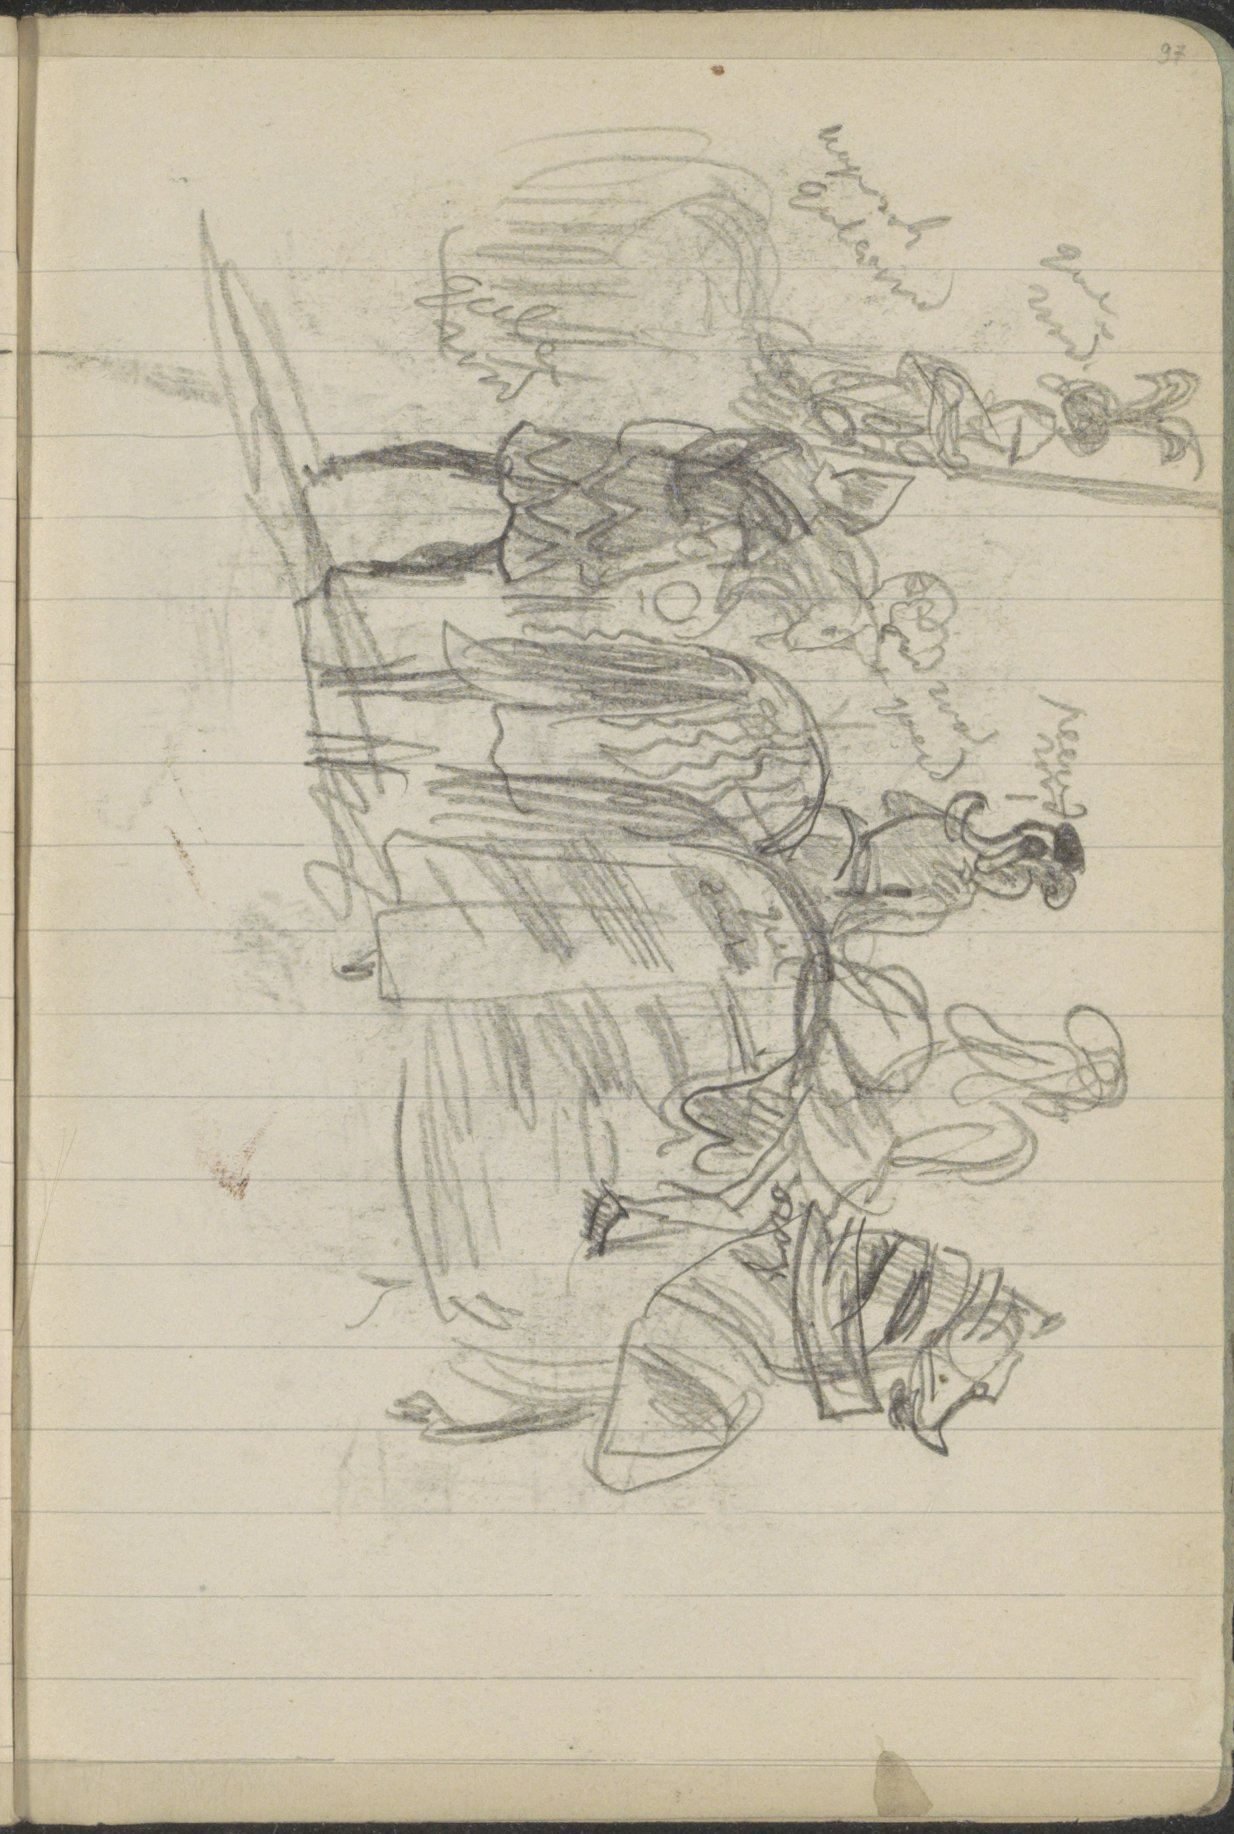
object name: sketchbook leaf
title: Ruiters in harnas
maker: marius bauer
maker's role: draughtsman, print maker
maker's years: 1867-1932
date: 1902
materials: pencil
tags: riding a horse, ass, or mule; rider, horseman, saddle and bridle (saddlery), armour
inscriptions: kleurnotitie, handgeschreven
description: Tevens een staande figuur in harnas. De paarden waarop de ruiters rijden zijn versierd. Pagina 97 uit een schetsboek met 50 bladen.